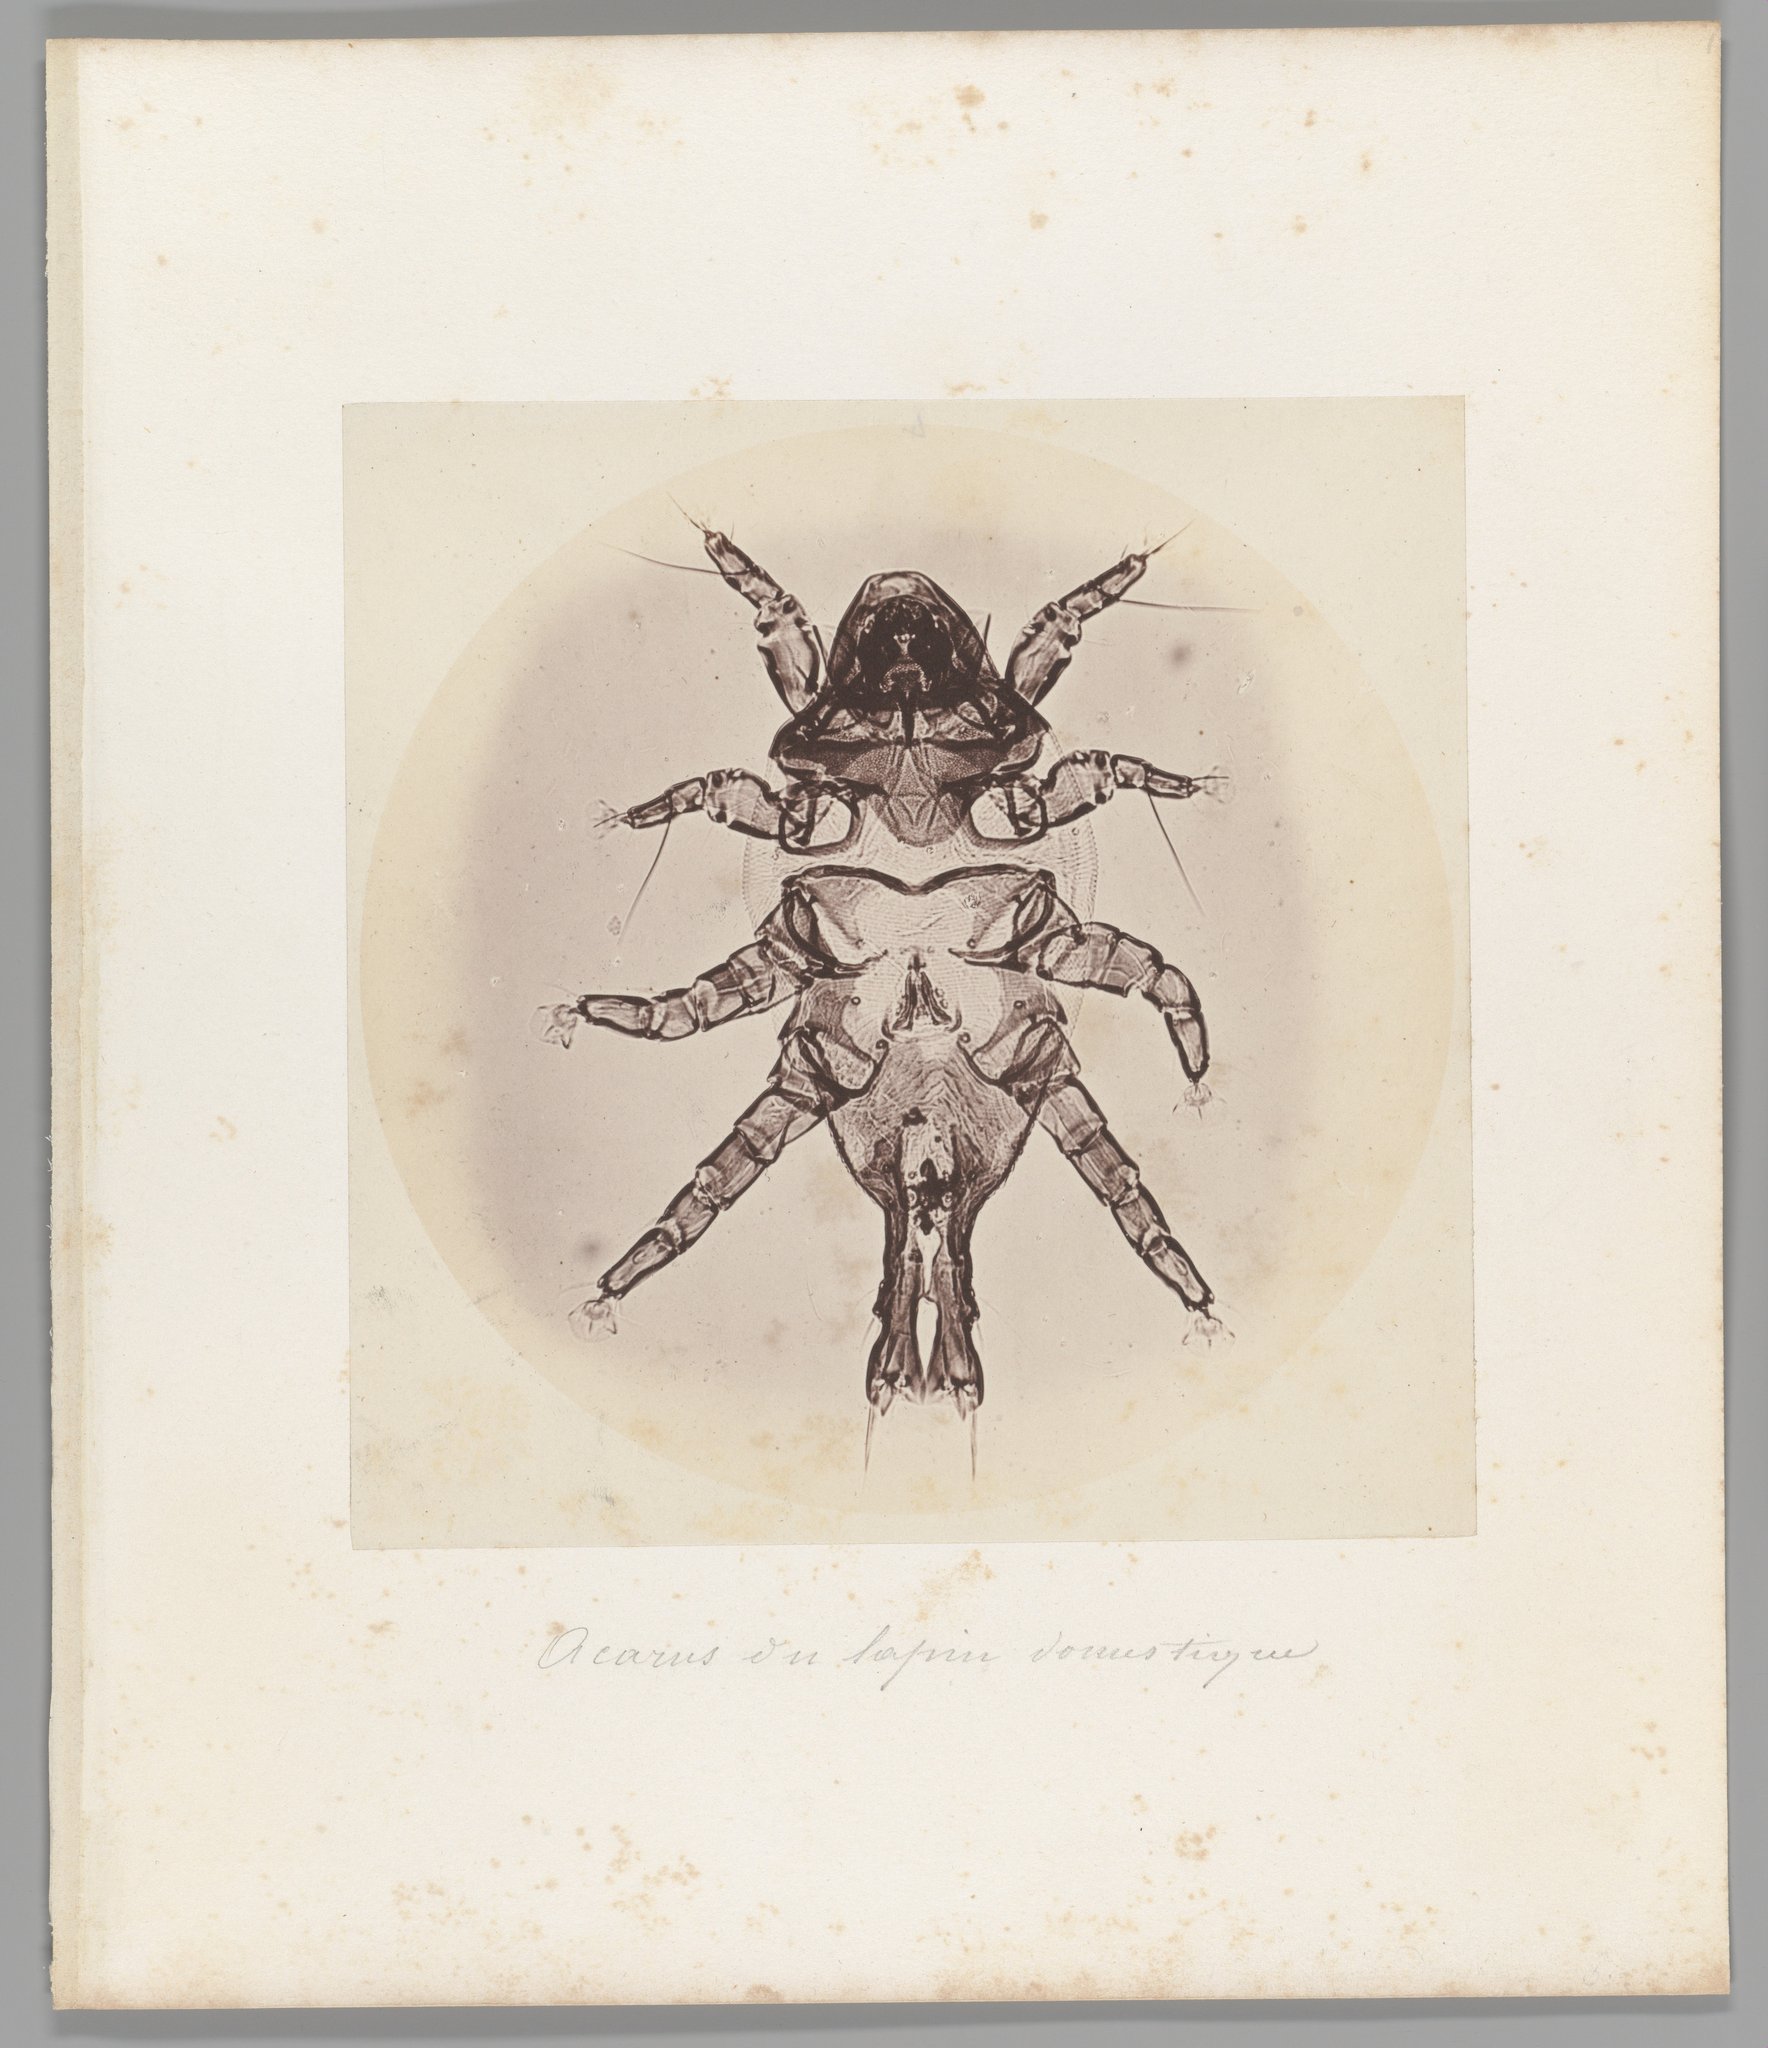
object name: photograph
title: [Untitled]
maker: auguste-adolphe bertsch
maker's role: artist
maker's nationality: french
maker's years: 1813-1871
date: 1853-1857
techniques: salted paper print